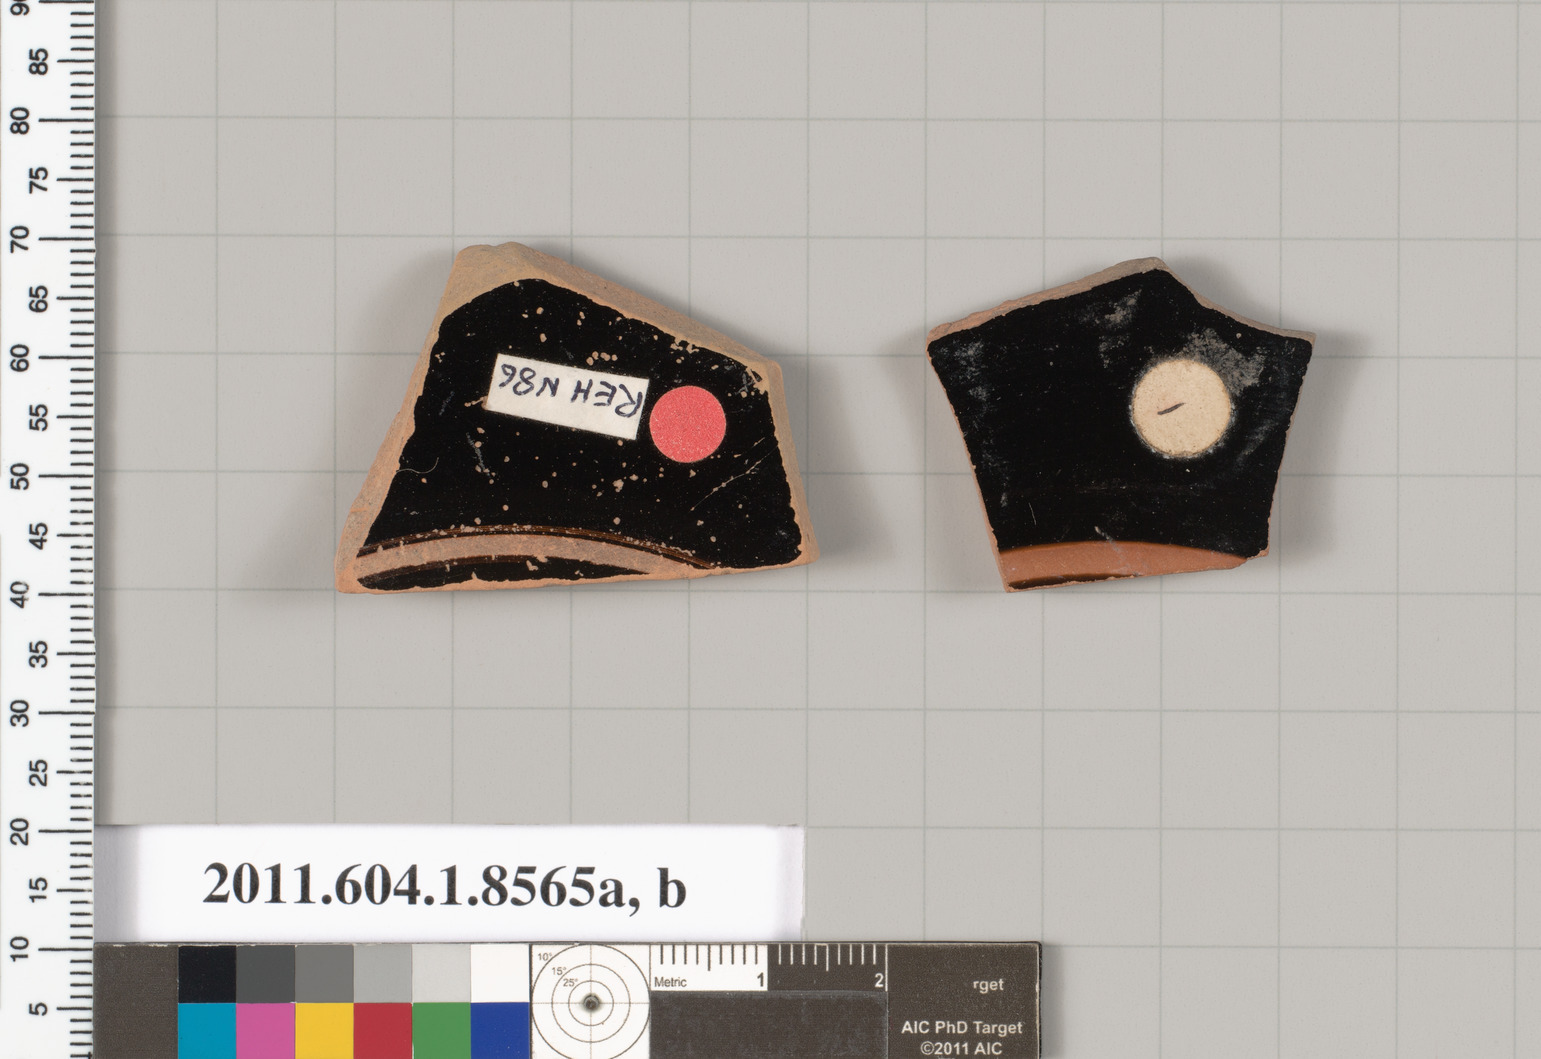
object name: kylix fragment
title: Terracotta fragments of stemless kylikes (drinking cups)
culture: greek, attic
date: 470-450 BCE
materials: terracotta